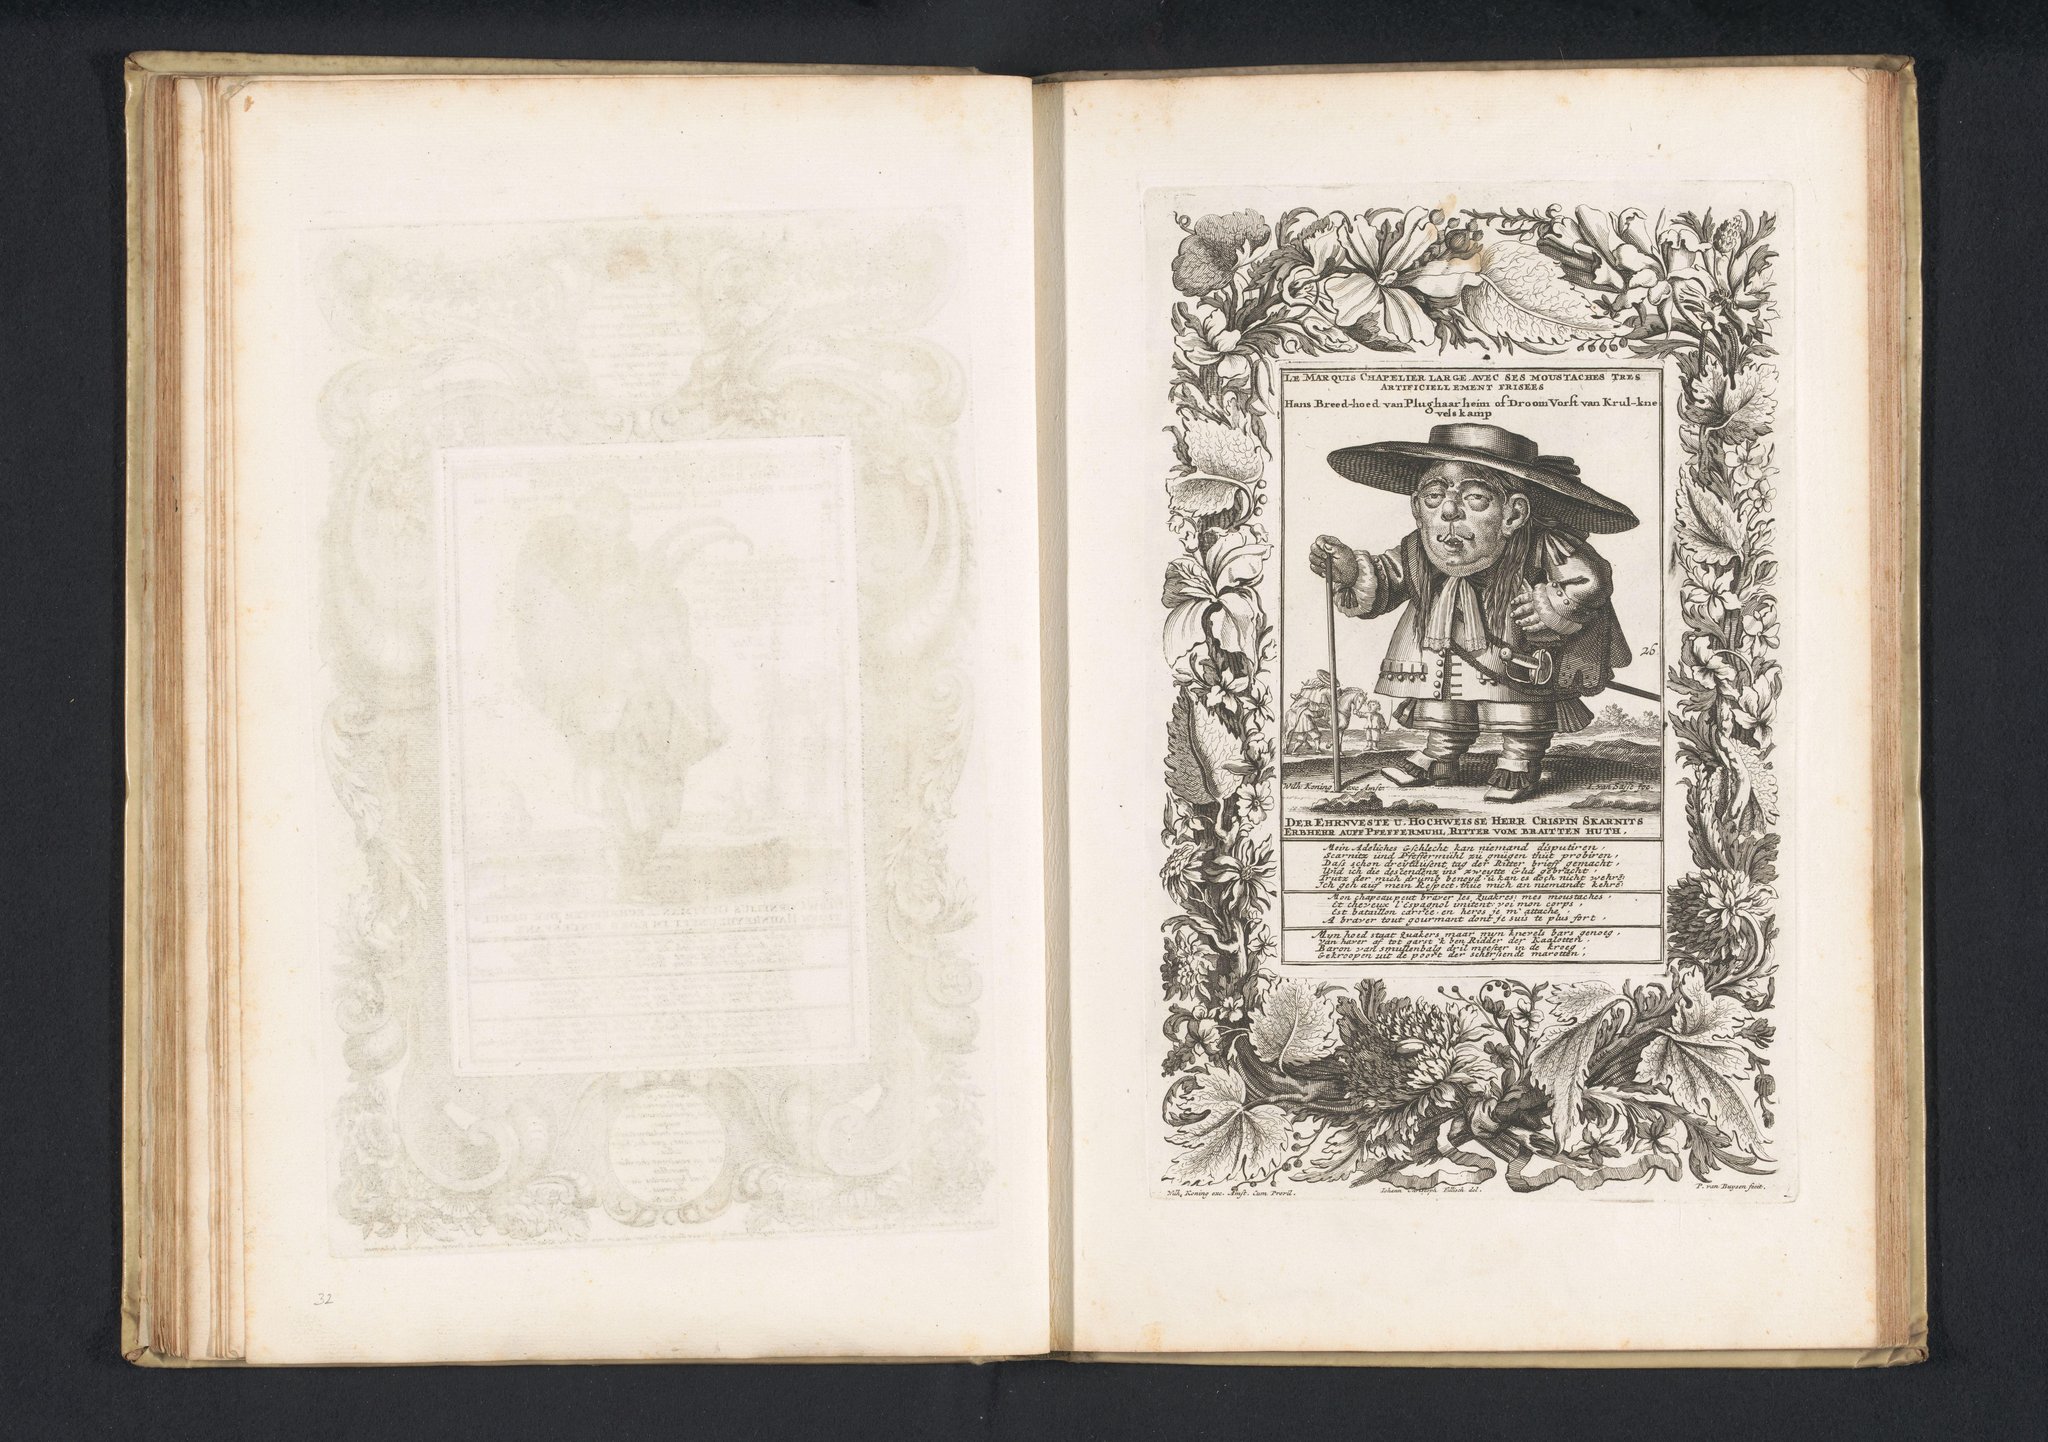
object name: caricature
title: De kleine mens Hans Breed-hoed van Plughaarheim, 1720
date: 1716-1720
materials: paper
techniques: etching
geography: northern netherlands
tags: caricatures (human types), little people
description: De kleine mens Hans Breed-hoed van Plughaarheim met brede hoed. In het onderschrift verzen in het Duits, Frans en Nederlands. Genummerd rechts midden: 26. Afdruk binnen een decoratieve omlijsting gedrukt van een aparte plaat met bloemen en bladeren. Onderdeel van deel II in de tweede Nederlandse gebonden uitgave uit 1720 (en gerelateerd aan de Windhandel in dat jaar) van een serie karikaturen van kleine mensen, bekend als Het Dwergentooneel, deels gekopieerd naar een ouder Duits voorbeeld.